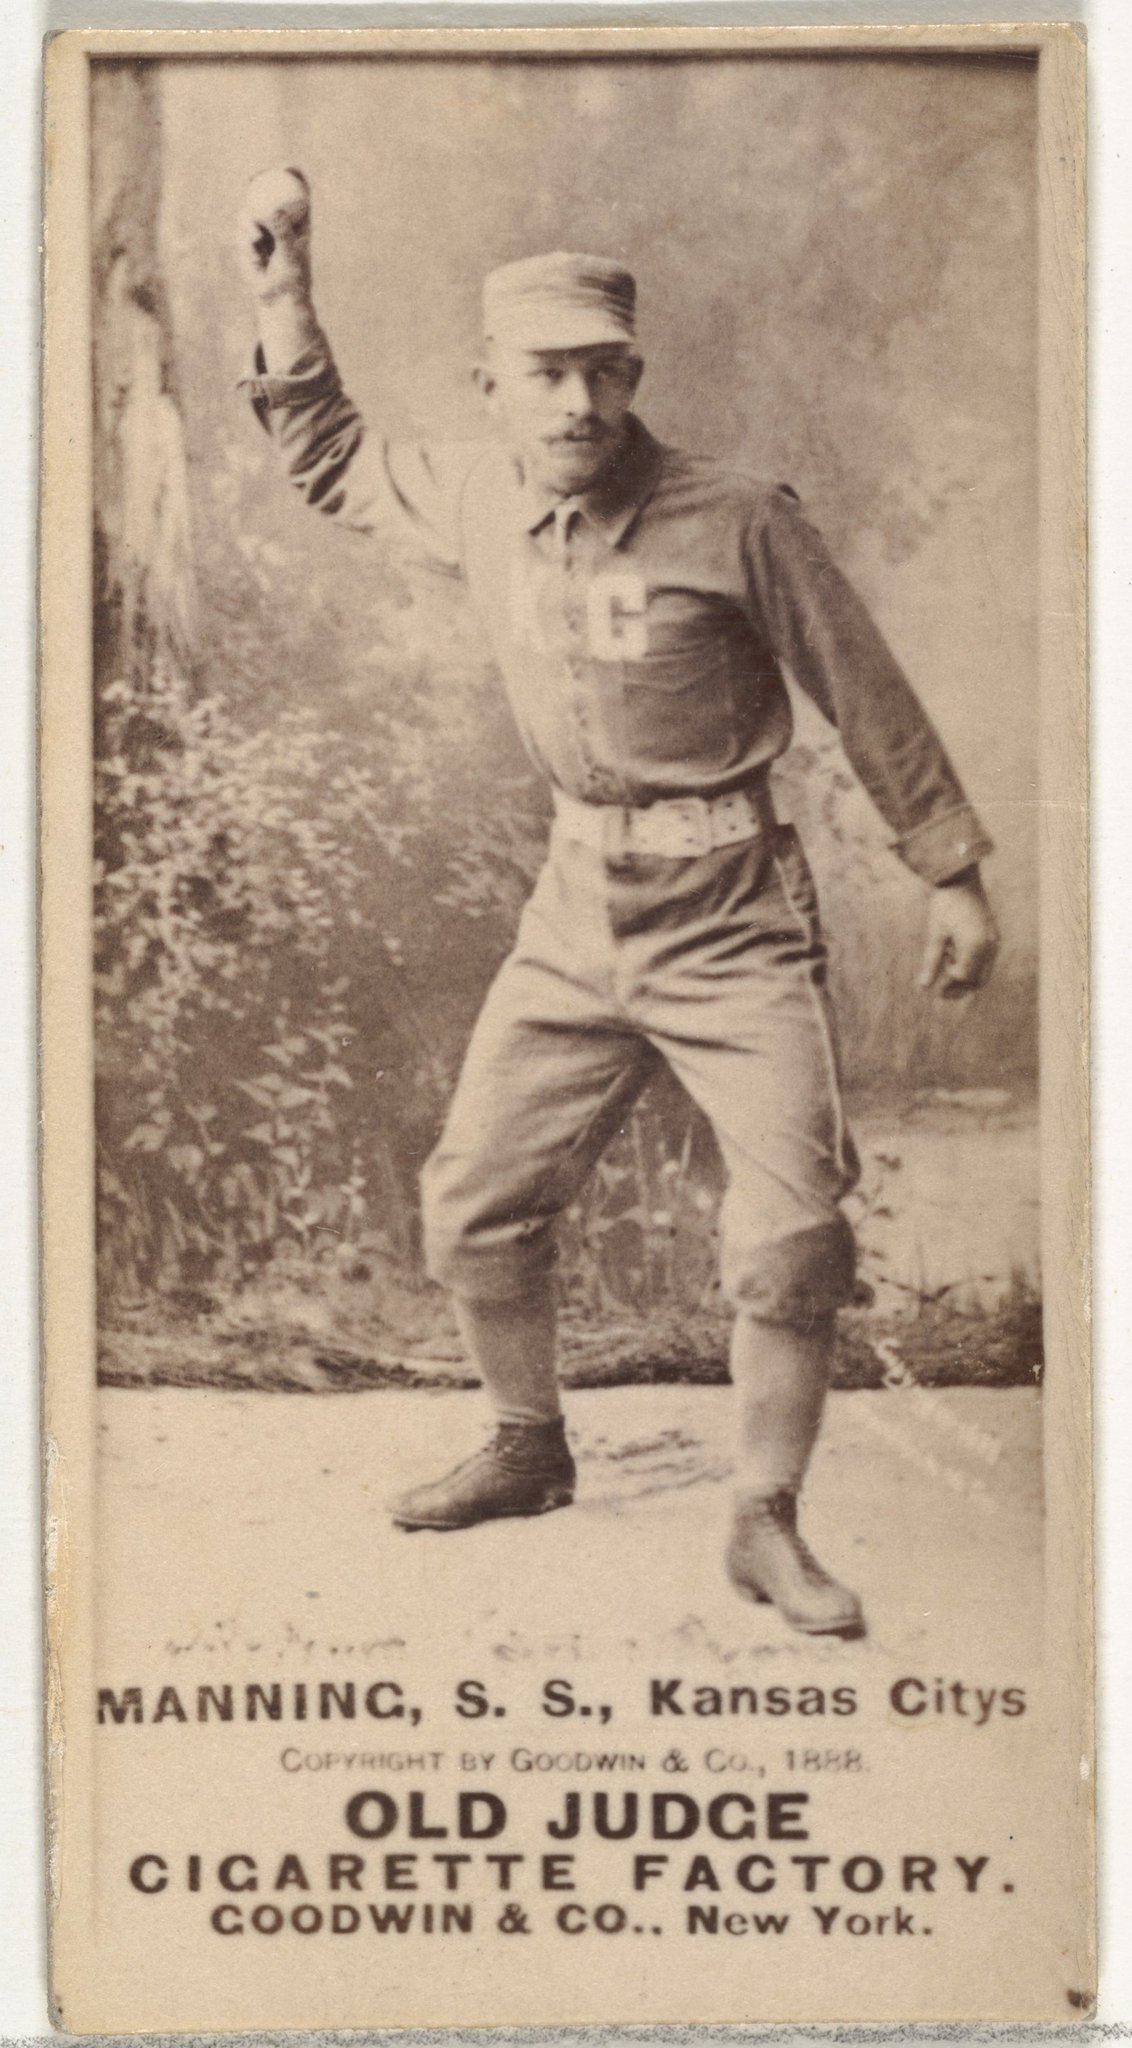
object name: baseball card, photograph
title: James H. "Jim" Manning, Shortstop, Kansas City Cowboys, from the Old Judge series (N172) for Old Judge Cigarettes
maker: goodwin & company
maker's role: publisher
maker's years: 1850-1950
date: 1888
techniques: albumen silver print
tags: men,portraits,baseball,athletes